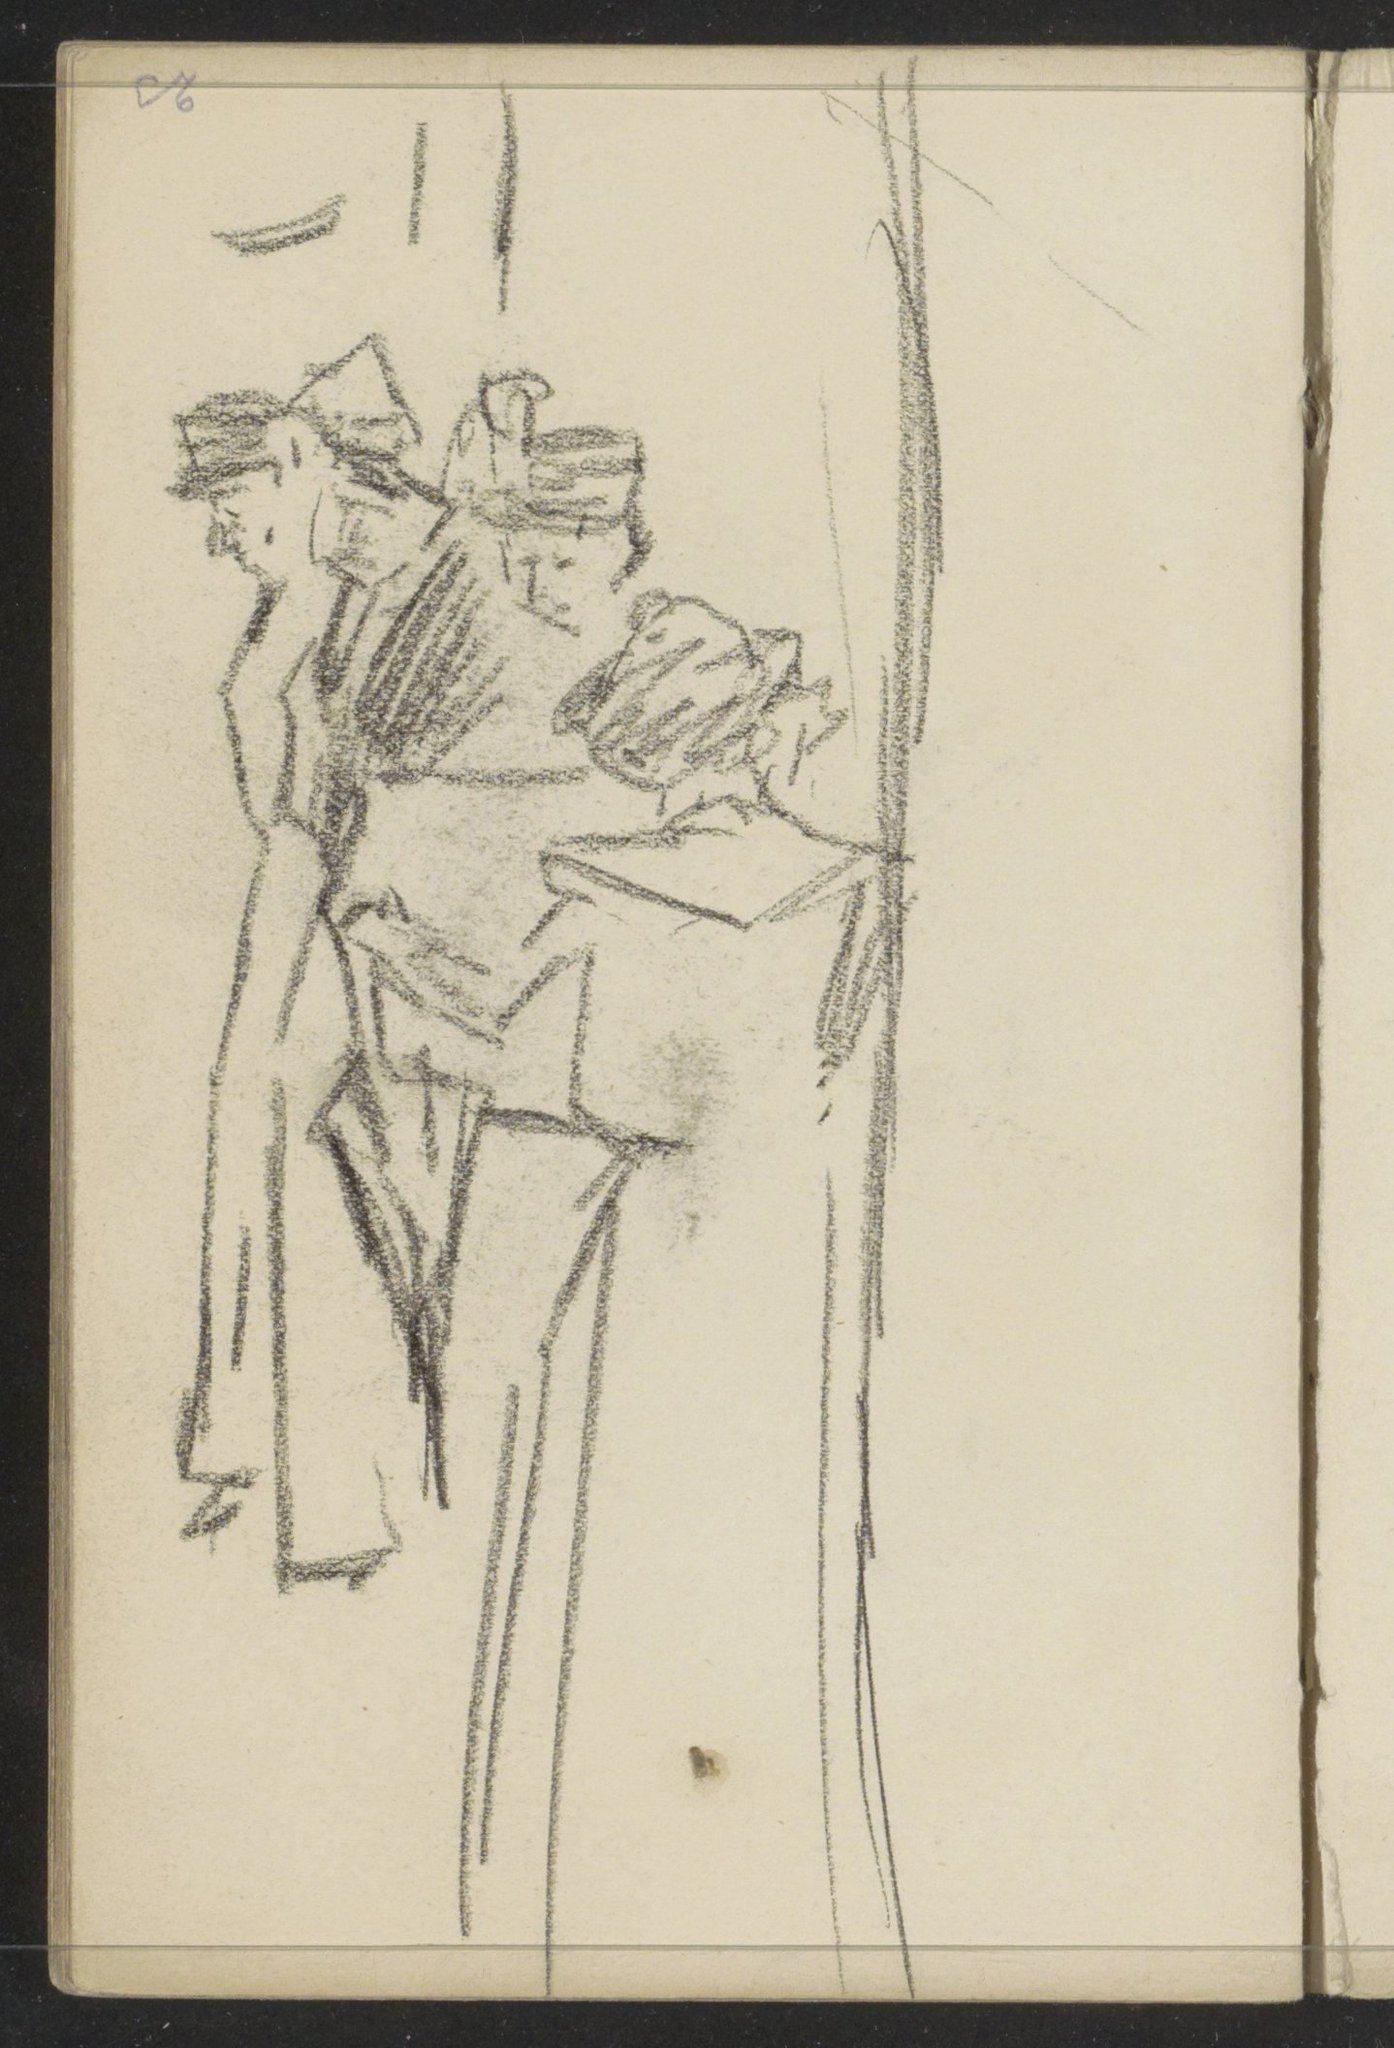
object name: sketchbook leaf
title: Groep staande vrouwen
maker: isaac israels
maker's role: draughtsman, painter, print maker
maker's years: 1865-1934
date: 1887-1934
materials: chalk, paper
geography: paris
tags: adult woman (+ standing)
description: Blad 20 verso uit schetsboek LIX met 21 bladen.